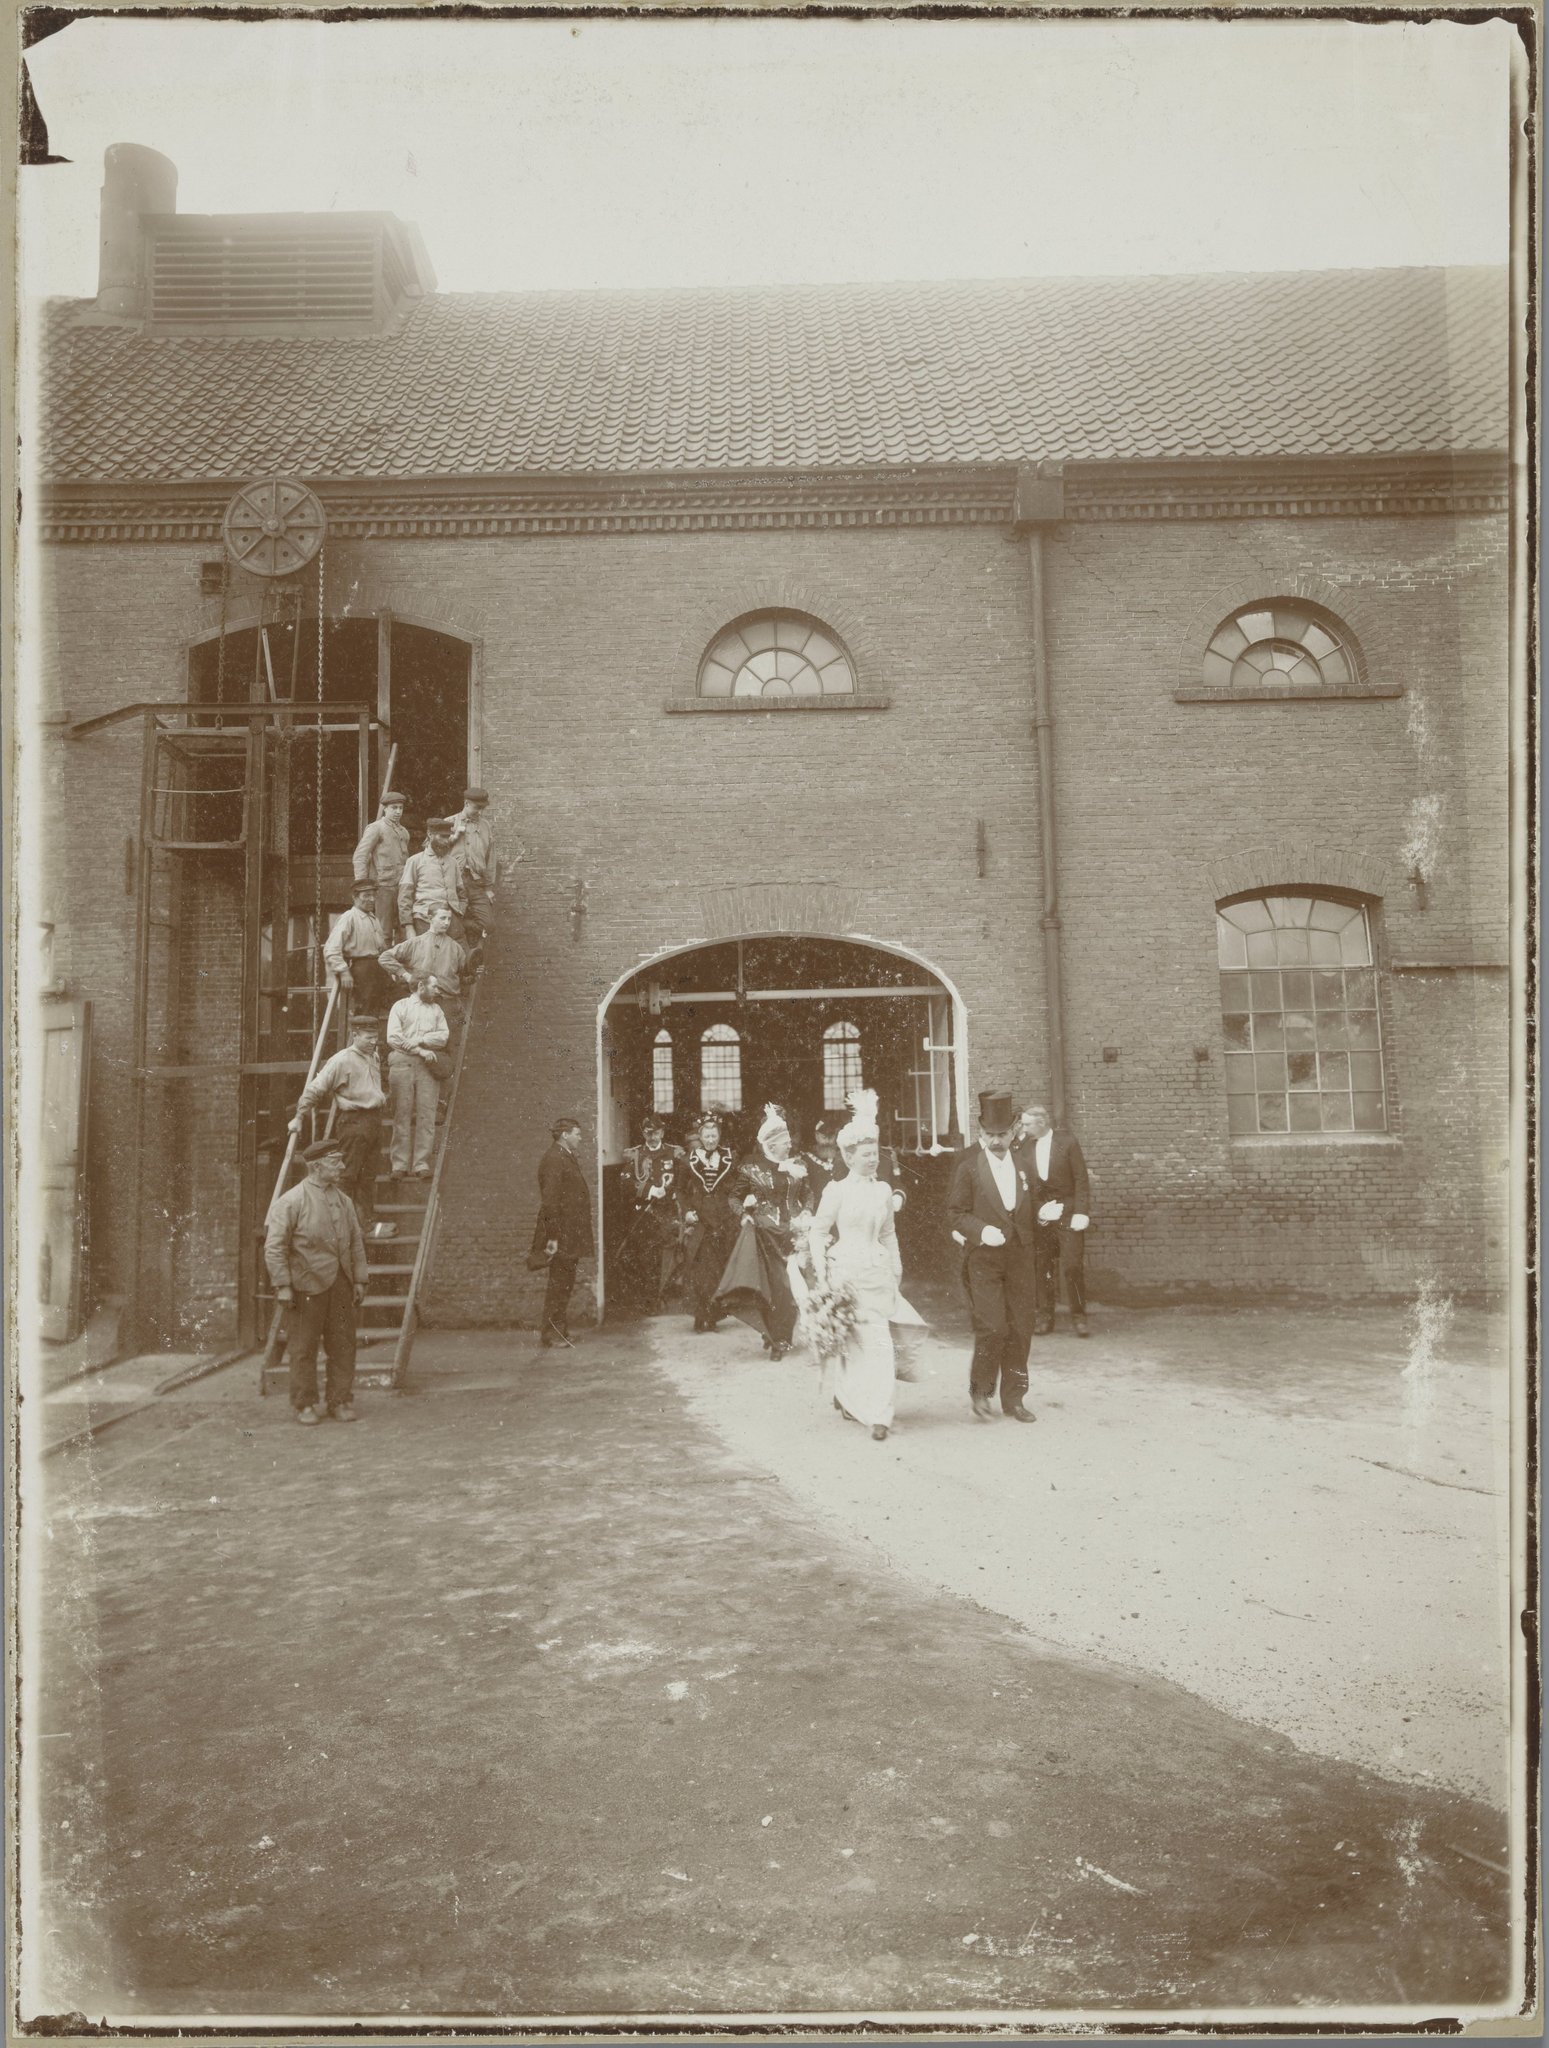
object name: photograph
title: Koningin Wilhelmina en koningin-moeder Emma op fabrieksbezoek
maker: Anonymous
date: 1898-1900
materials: cardboard, photographic support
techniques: albumen print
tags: the hague, wilhelmina of the netherlands, emma (queen consort of the netherlands)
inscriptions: name: ‘L.M. Lammerse Kantoor-boekhandel no 41 Hoofdsteeg Rotterdam’